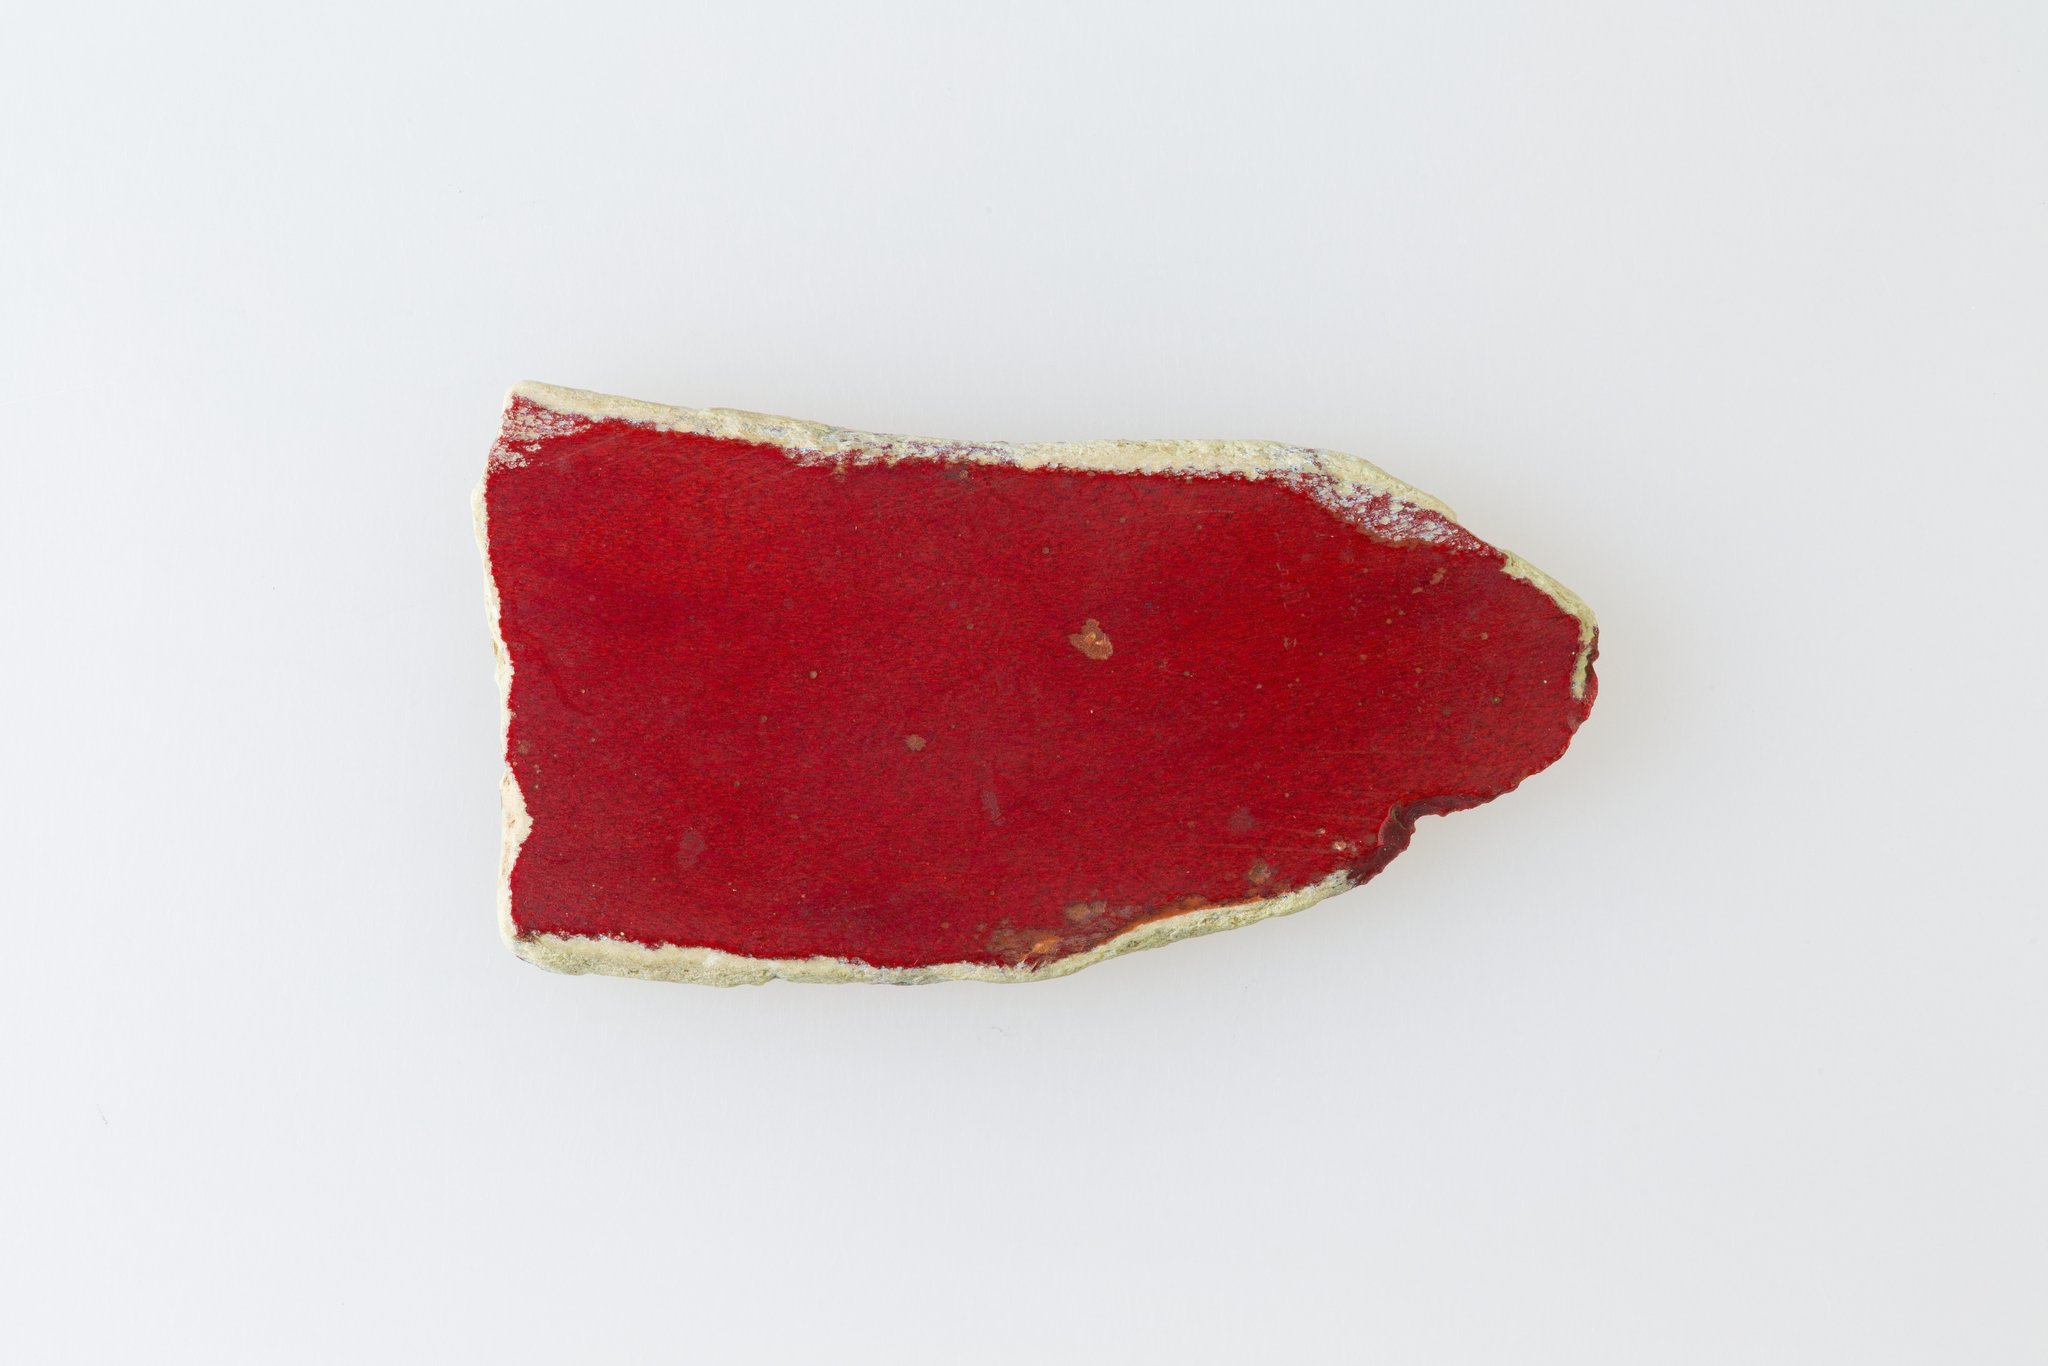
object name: wall revetment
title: Wall revetment, marble pattern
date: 200 BCE-100 CE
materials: glass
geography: egypt